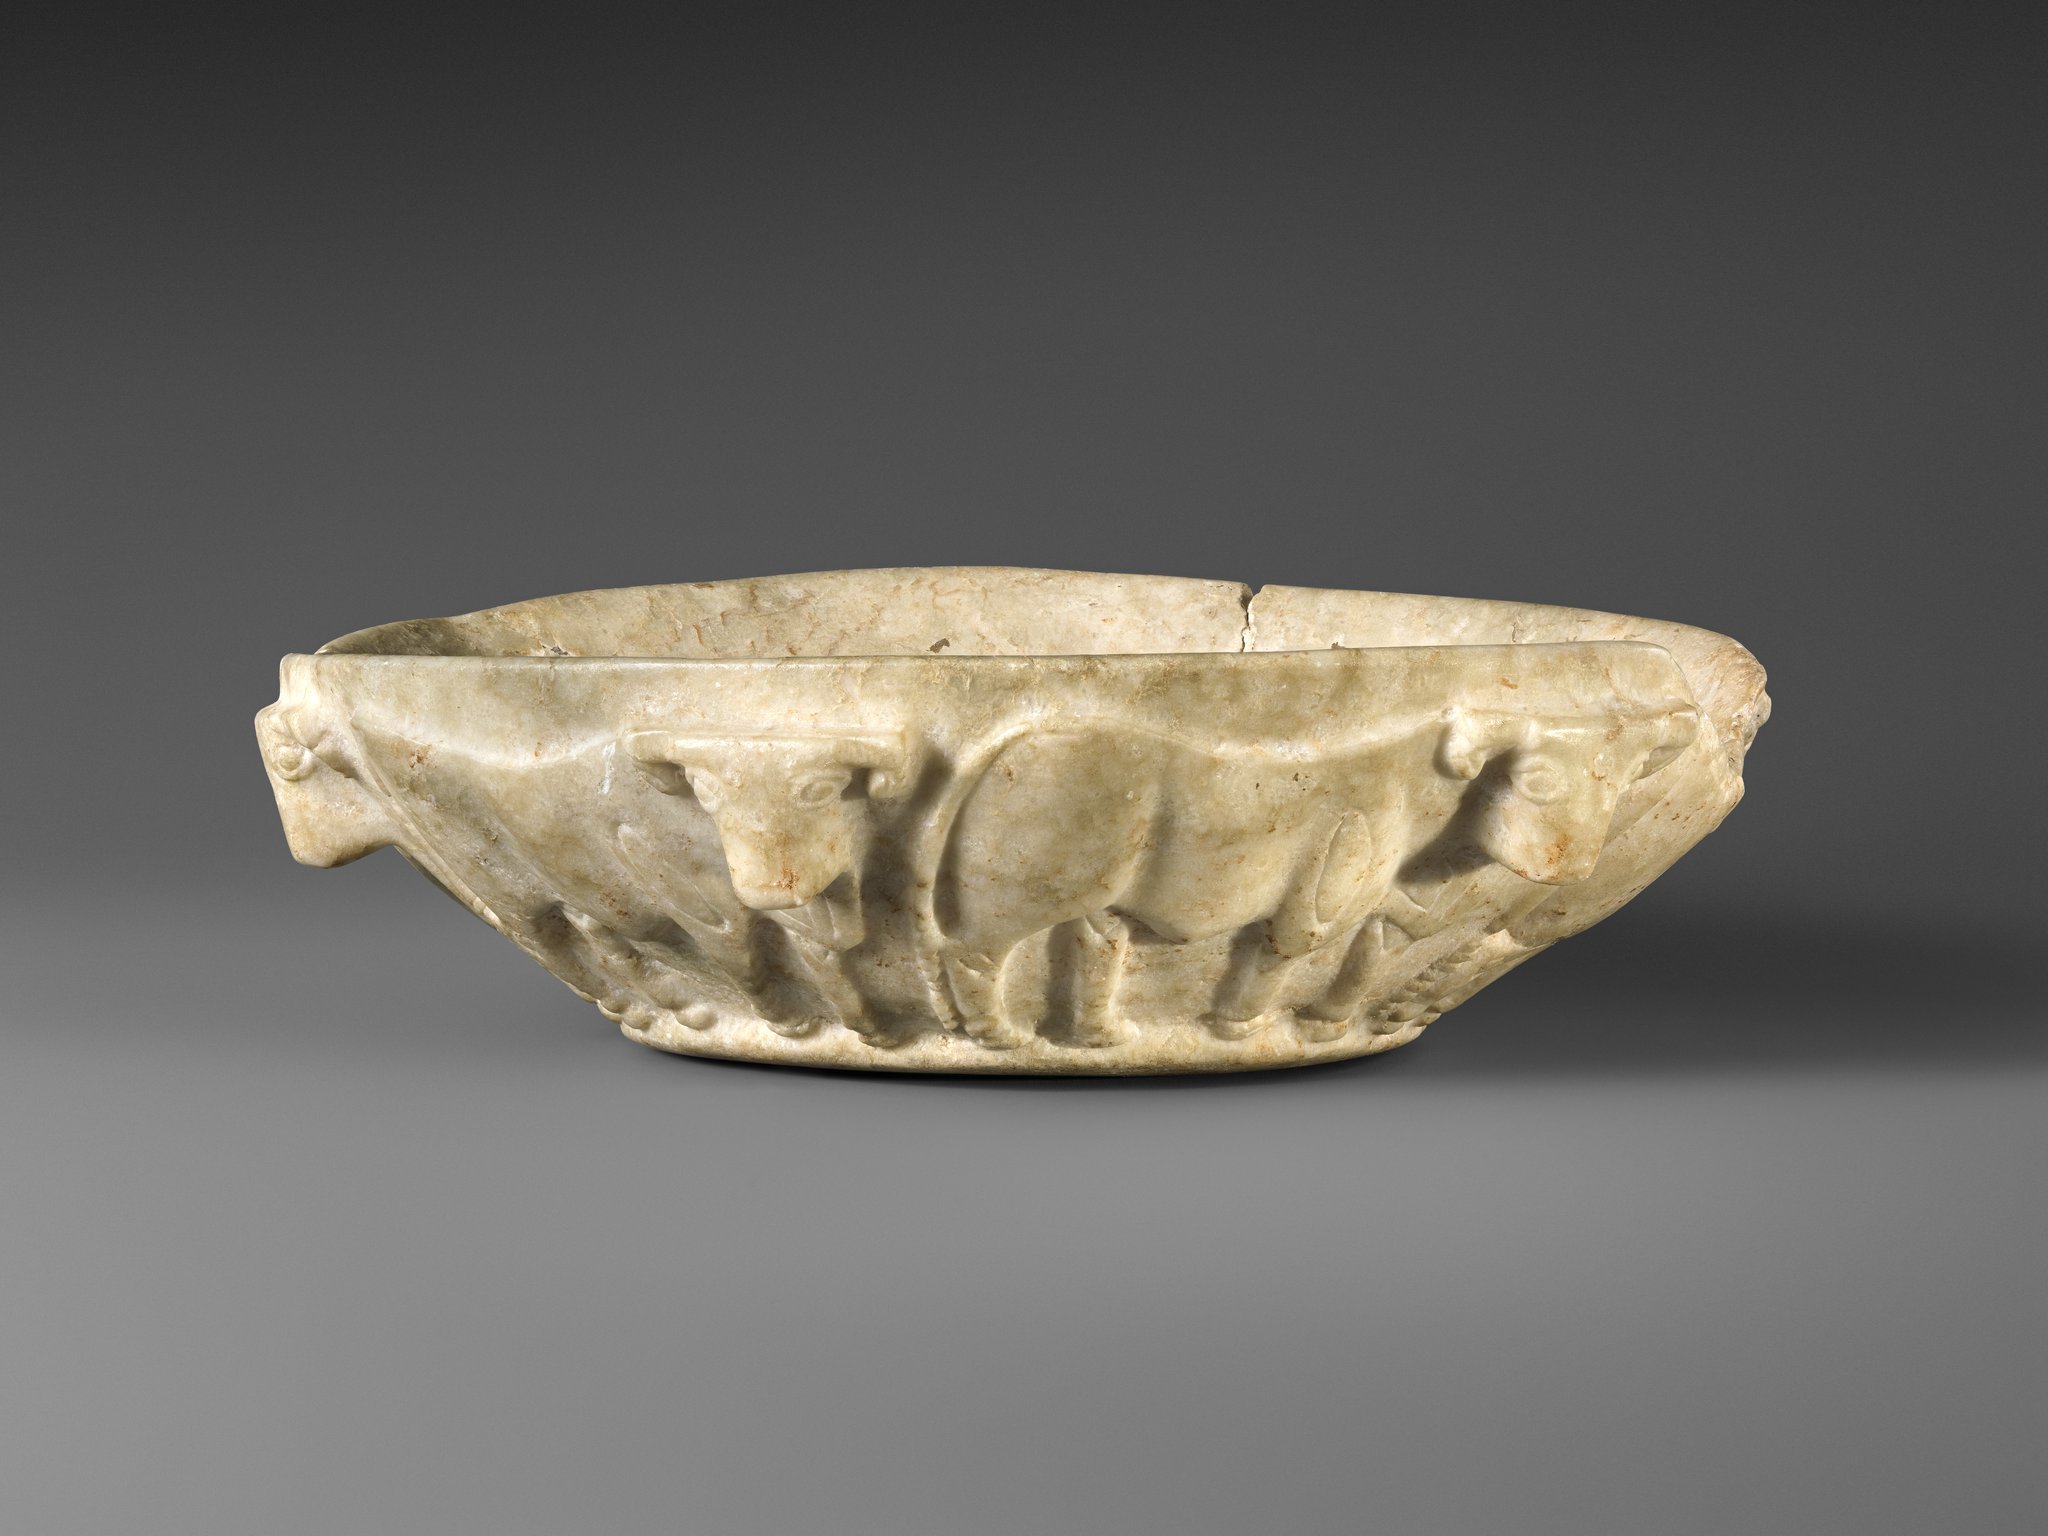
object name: bowl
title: Bowl with procession of bulls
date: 2900-2700 BCE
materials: marble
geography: southern mesopotamia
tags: bulls